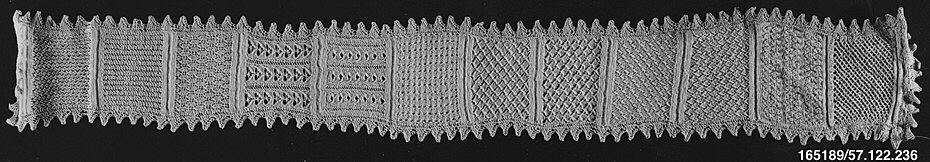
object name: sampler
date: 1801-1900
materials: wool